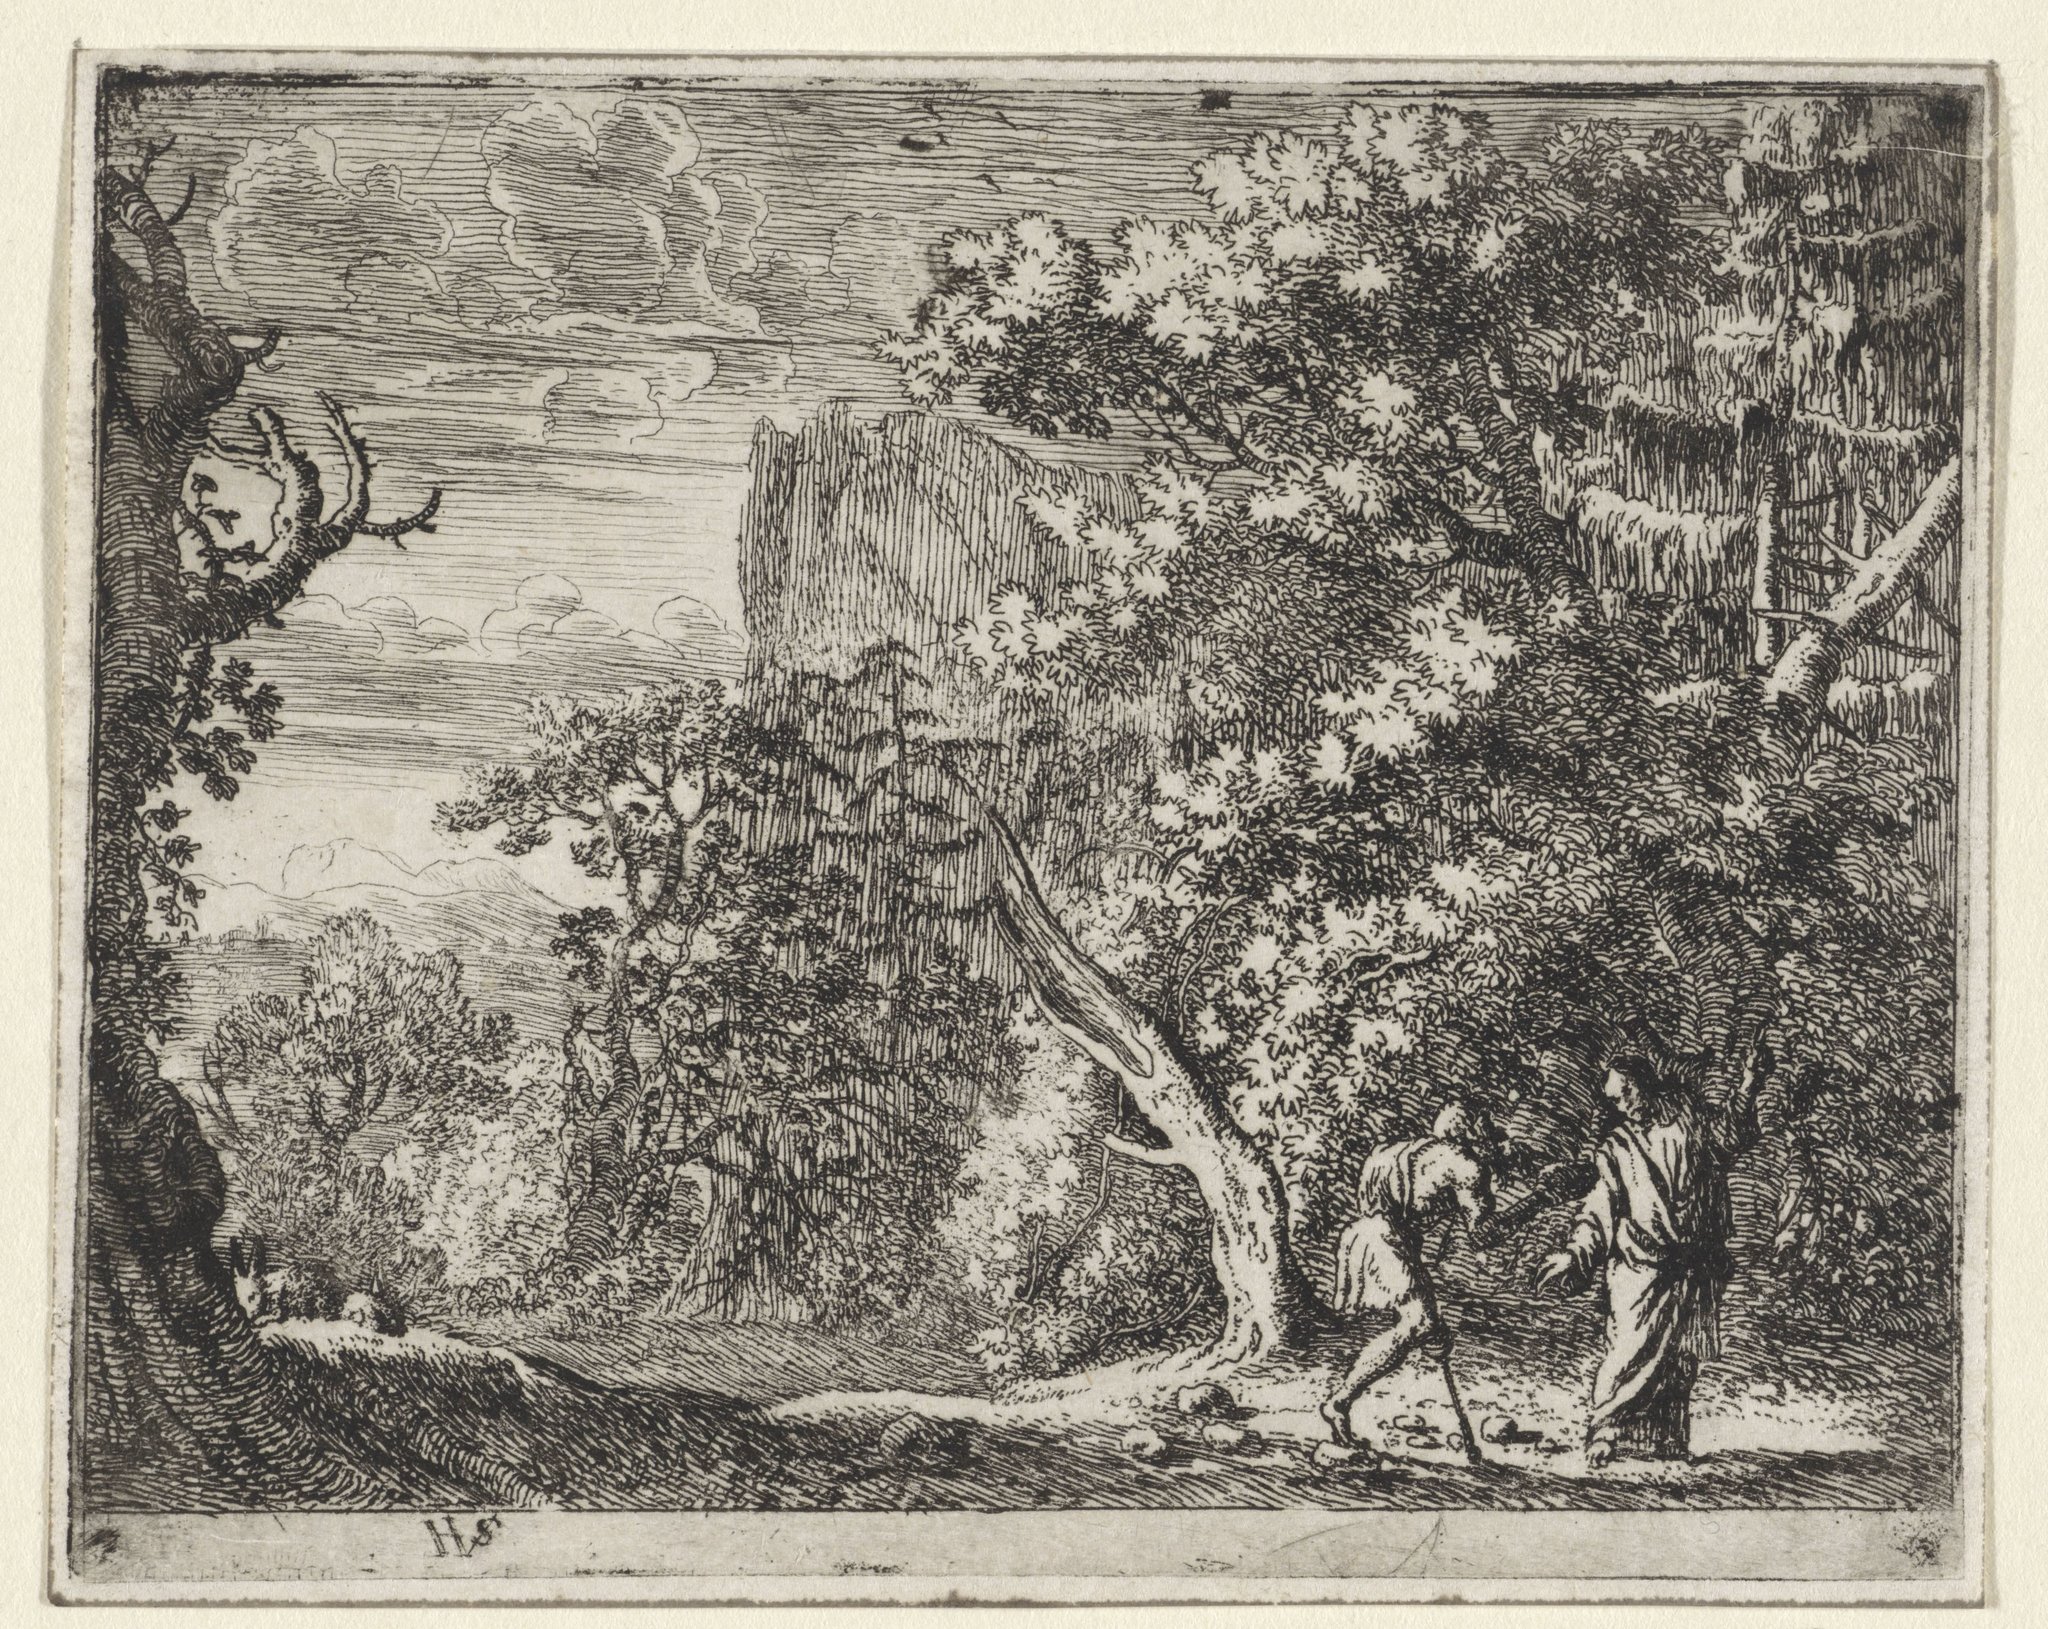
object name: print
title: Verzoeking van Christus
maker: herman van swanevelt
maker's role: draughtsman, painter, print maker, publisher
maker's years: 1603-1655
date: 1623-1655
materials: paper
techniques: etching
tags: christ, sometimes accompanied by guardian angel(s), tempted by satan, who usually appears in human form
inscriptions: collector's mark: Lugt 2228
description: In een bosrijk landschap wordt Christus rechts op de voorgrond benaderd door Satan in de gedaante van een oude man met een houten been. Met zijn rechterhand biedt hij Christus een steen aan.